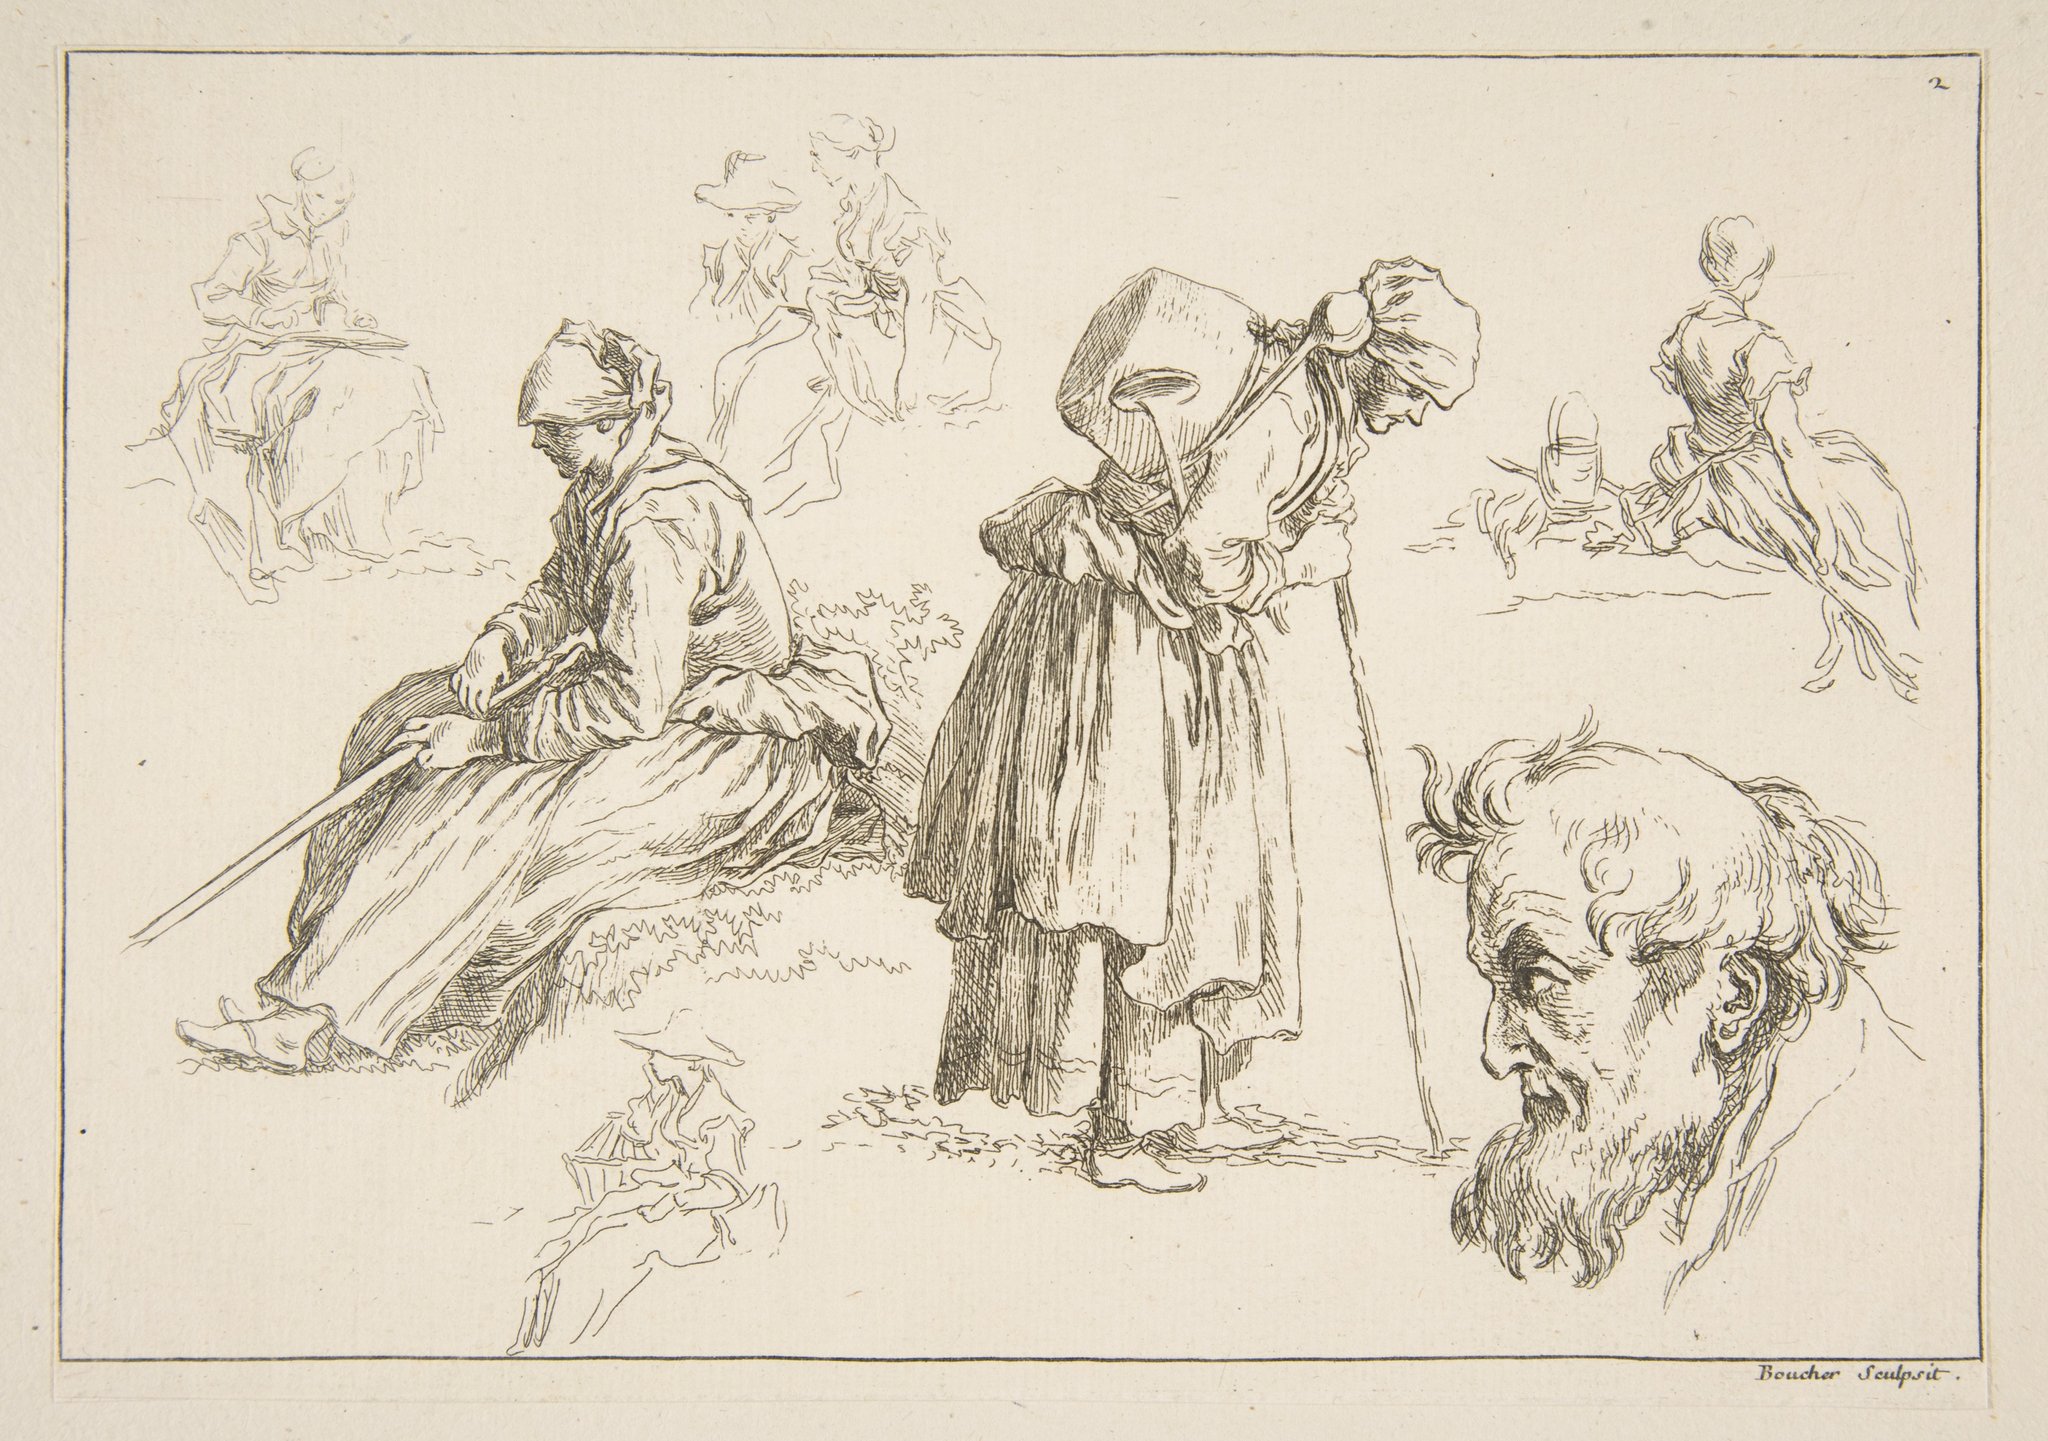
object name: print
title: Sheet of Sketches, from "Livre d’étude d’après les desseins originaux de Blomart"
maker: françois boucher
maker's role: artist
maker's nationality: french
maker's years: 1703-1770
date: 1735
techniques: etching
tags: men,profiles,women